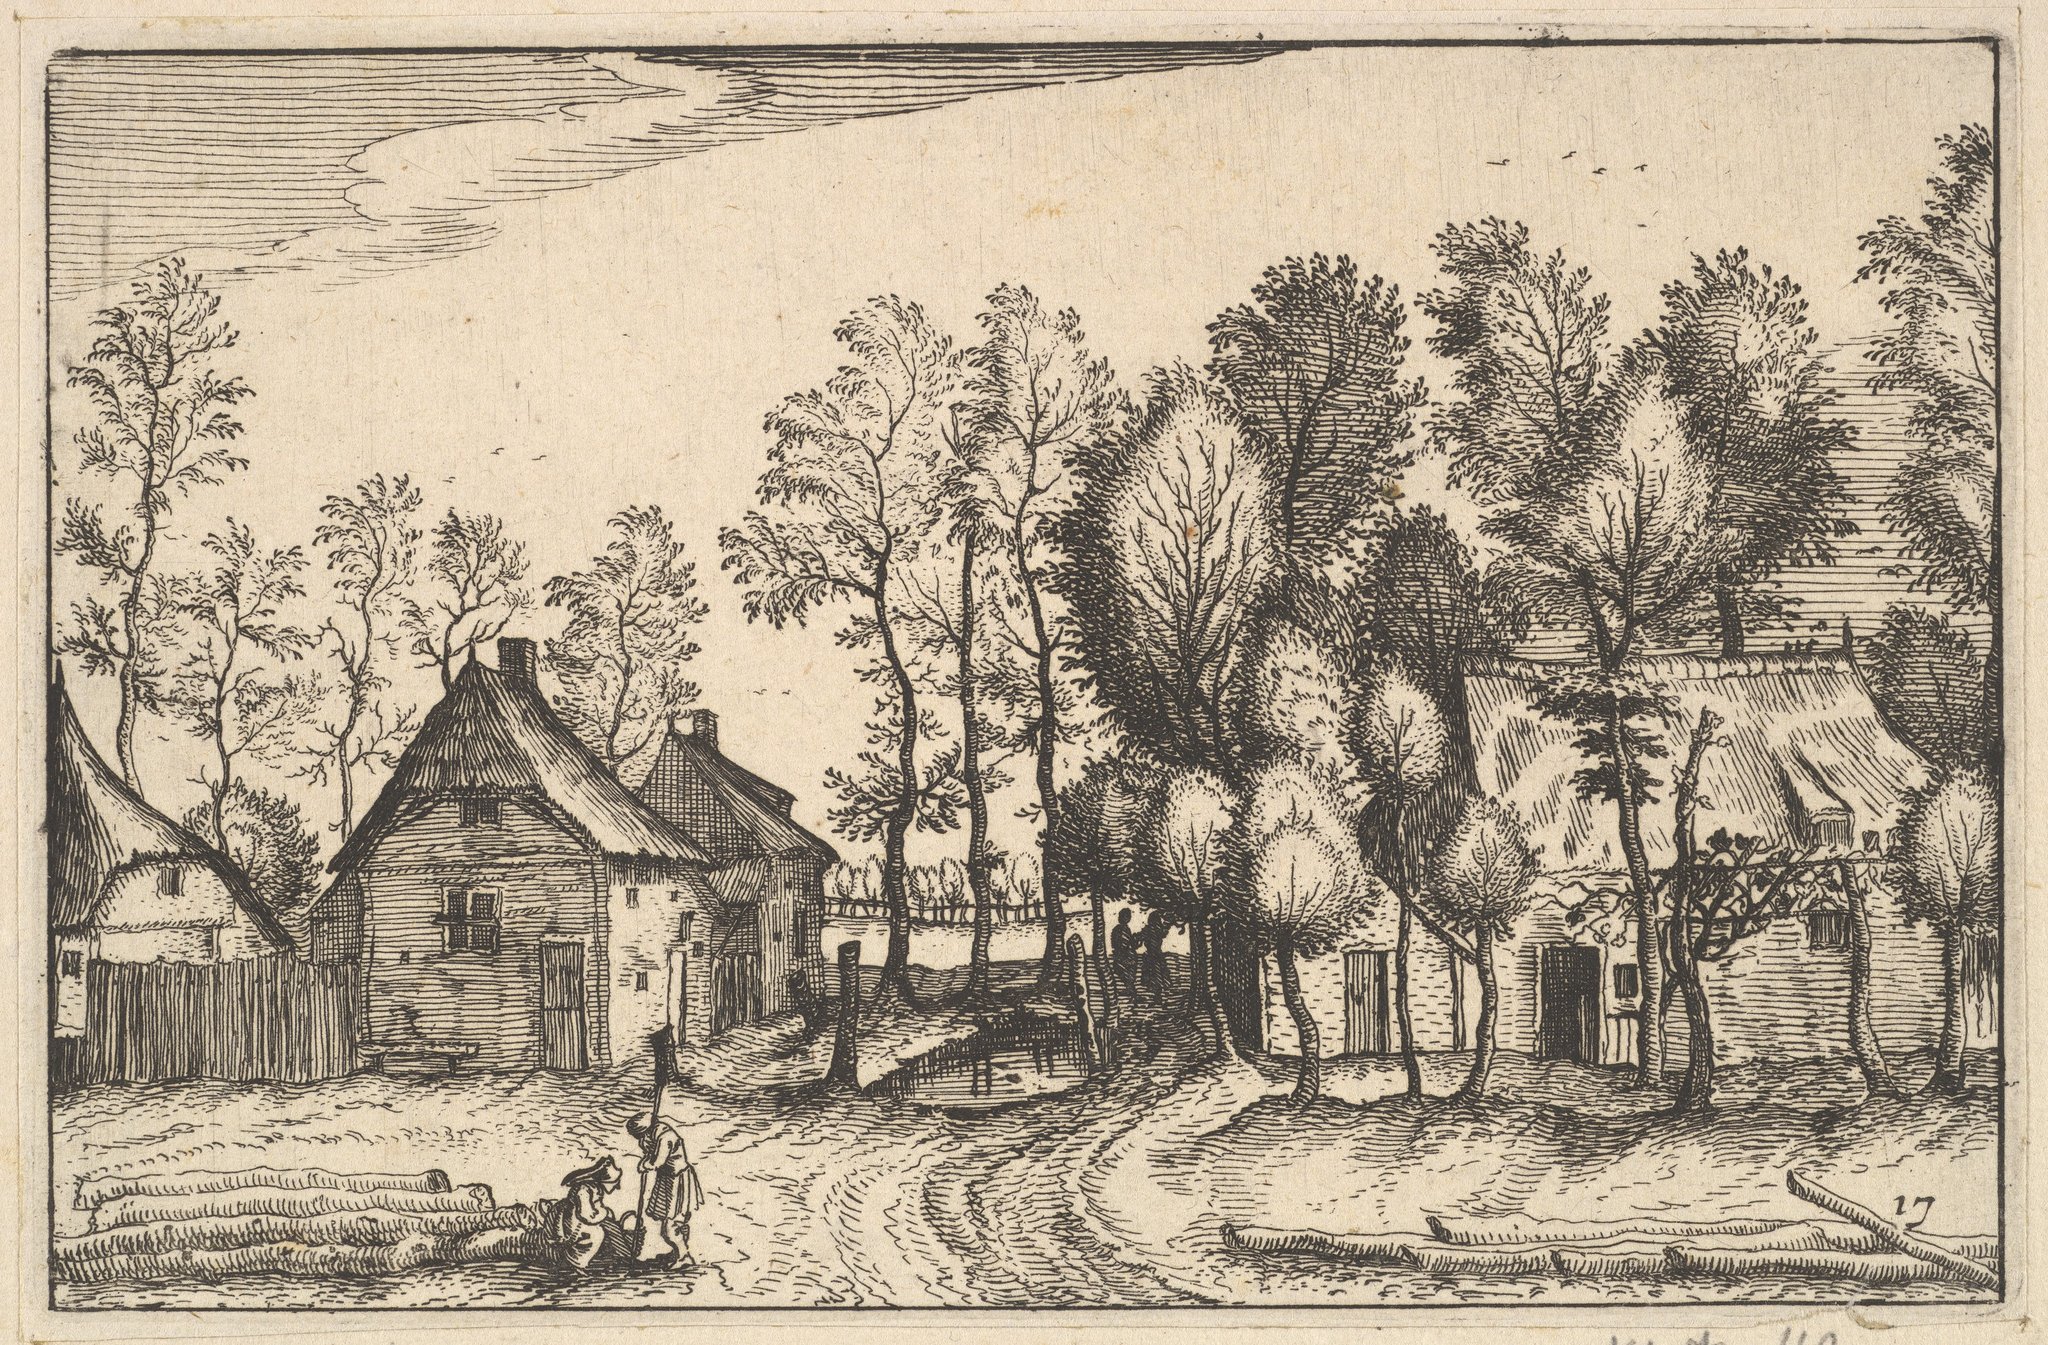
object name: print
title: Landscape with Hewed Trees, plate17 from "Regiunculae et Villae Aliquot Ducatus Brabantiae"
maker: claes jansz. visscher (ii)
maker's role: artist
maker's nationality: dutch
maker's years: 1586-1652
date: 1610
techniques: etching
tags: houses,landscapes,trees